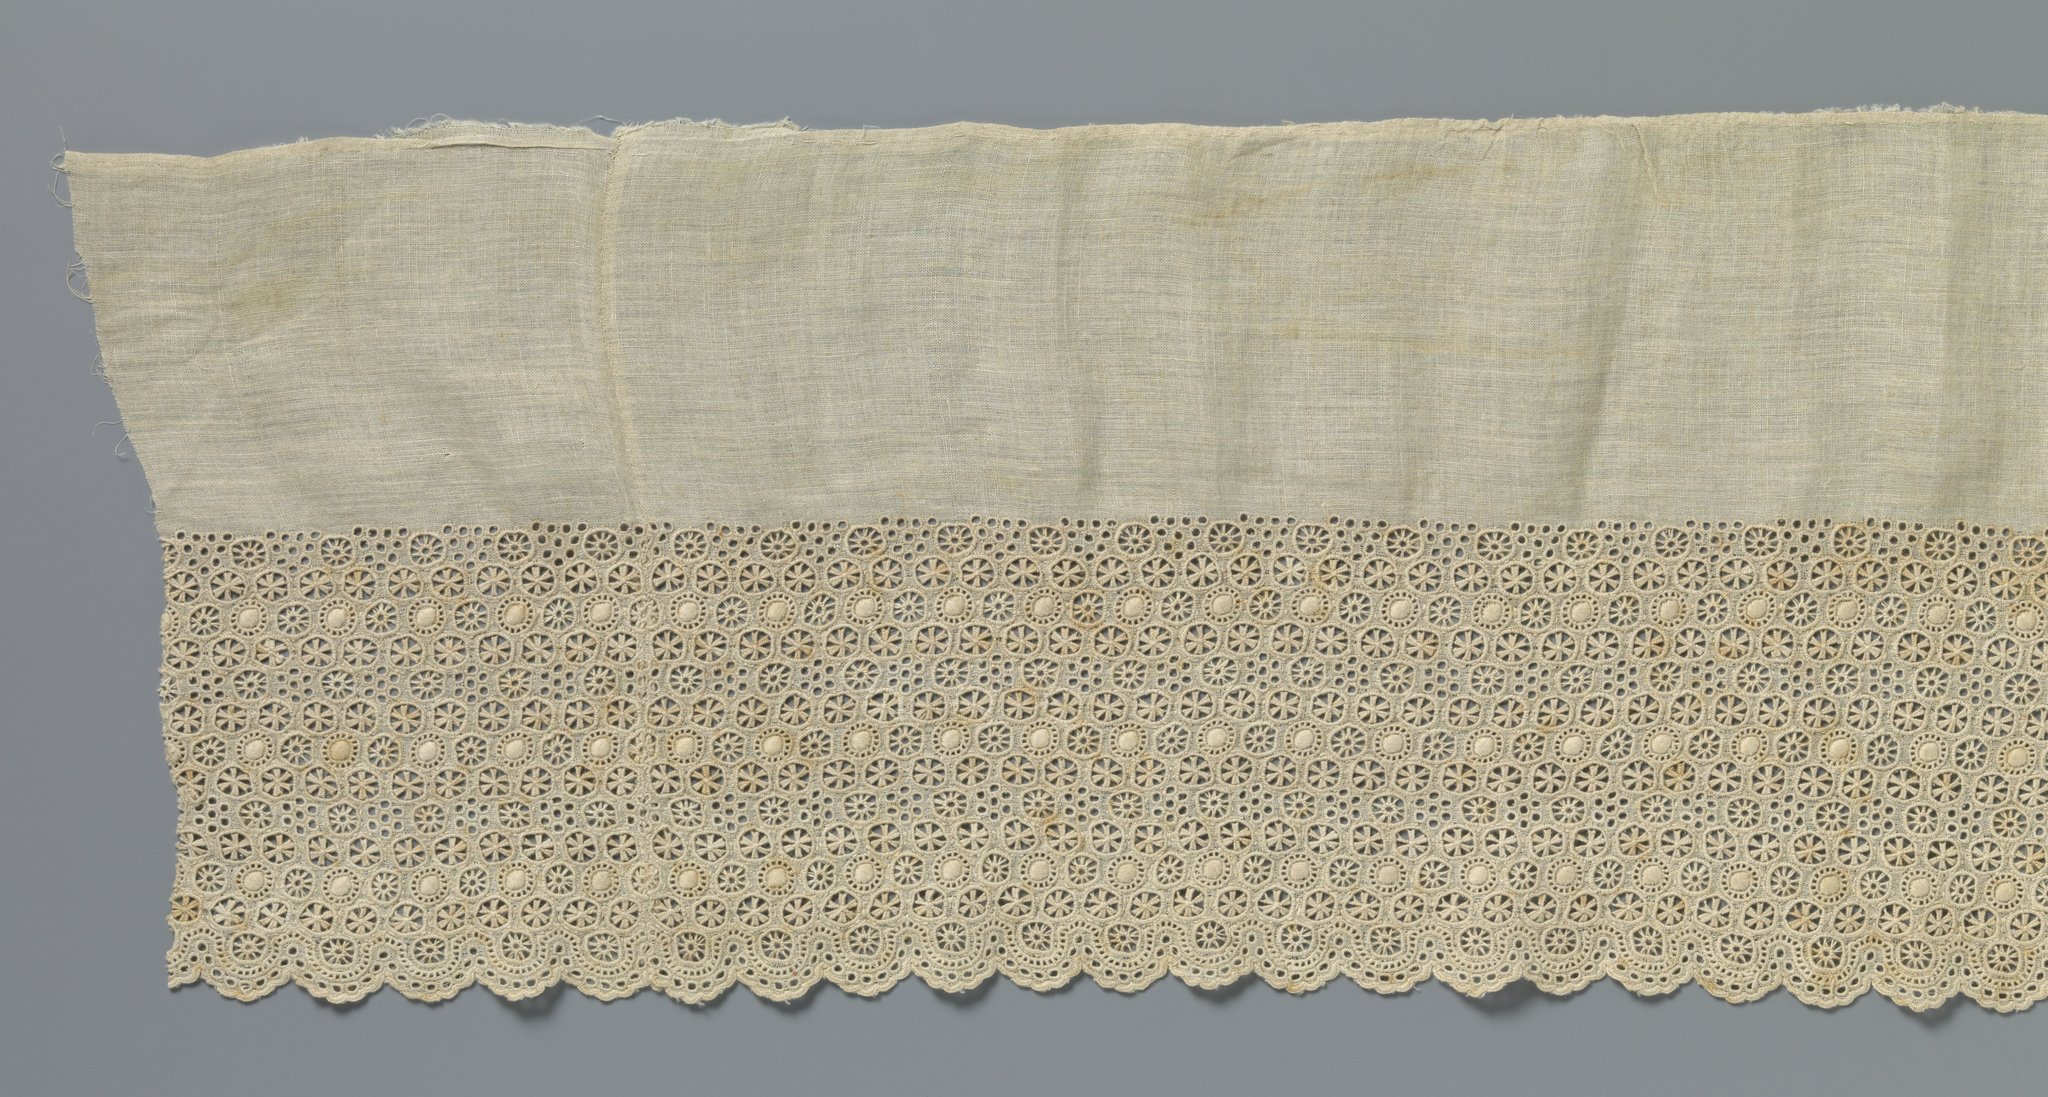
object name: strip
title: Strook linnen met opengewerkte cirkeltjes met zonnetjes en sterretjes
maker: Anonymous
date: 1920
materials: linen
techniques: embroidered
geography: dutch east indies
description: Strook naturelkleurig linnen met opengewerkte cirkeltjes: Engels borduurwerk. De onderste helft van de strook is bewerkt. Het patroon bestaat uit dertien rijen opengewerkte cirkeltjes met geborduurde randen. In het centrum zijn de cirkeltjes versierd met afwisselend zonnetjes, sterretjes en radertjes. In enkele rijen komen ook rozetjes voor, die zijn gemaakt met een kleiner opengewerkt cirkeltje waaromheen zes andere cirkeltjes als bloemblaadjes liggen. Tussen de opeenvolgende cirkeltjes in de bovenste rij zijn met steeds tien van deze kleine cirkeltjes driehoekjes opgebouwd. De schulpenrand langs de onderzijde van de strook is afgewerkt met een golvende lijn van deze kleine cirkeltjes, waaromheen per schulp kleine lobjes zijn gemaakt. De strook is vermoedelijk bedoeld of gebruikt voor bevestiging aan een japon.